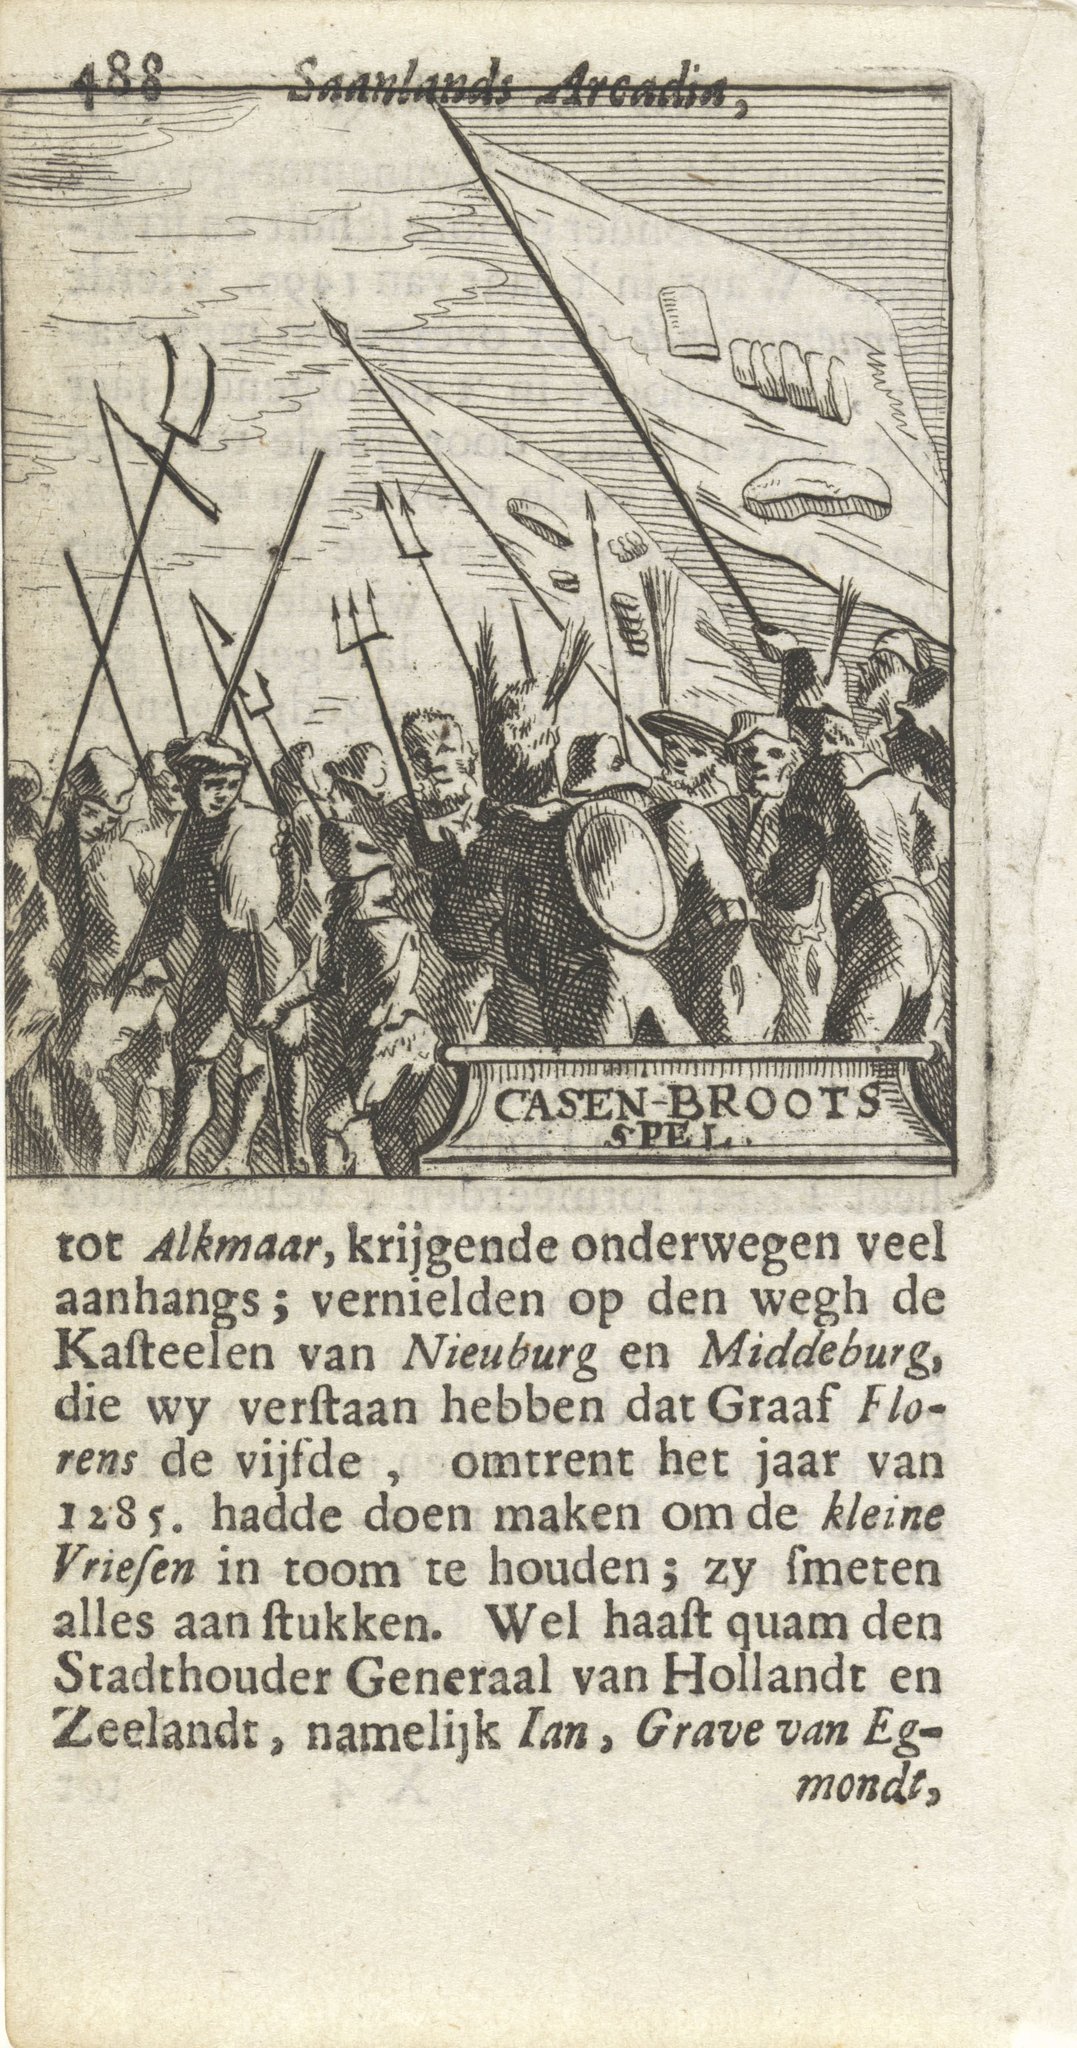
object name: book illustration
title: Casen-brootsspel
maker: hendrik jacobsz soeteboom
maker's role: print maker, publisher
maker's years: 1616-1678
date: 1658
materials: paper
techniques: engraving, etching, letterpress printing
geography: zaandam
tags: street-fights, riots, netherlands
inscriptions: collector's mark: Lugt 2760, collector's mark: Lugt 2228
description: Gebruikt als illustratie op p. 488 van: Hendrik Jacobsz Soeteboom. De Zaanlants Arkadia. Amsterdam: Gerrit van Goedesberg, 1658.